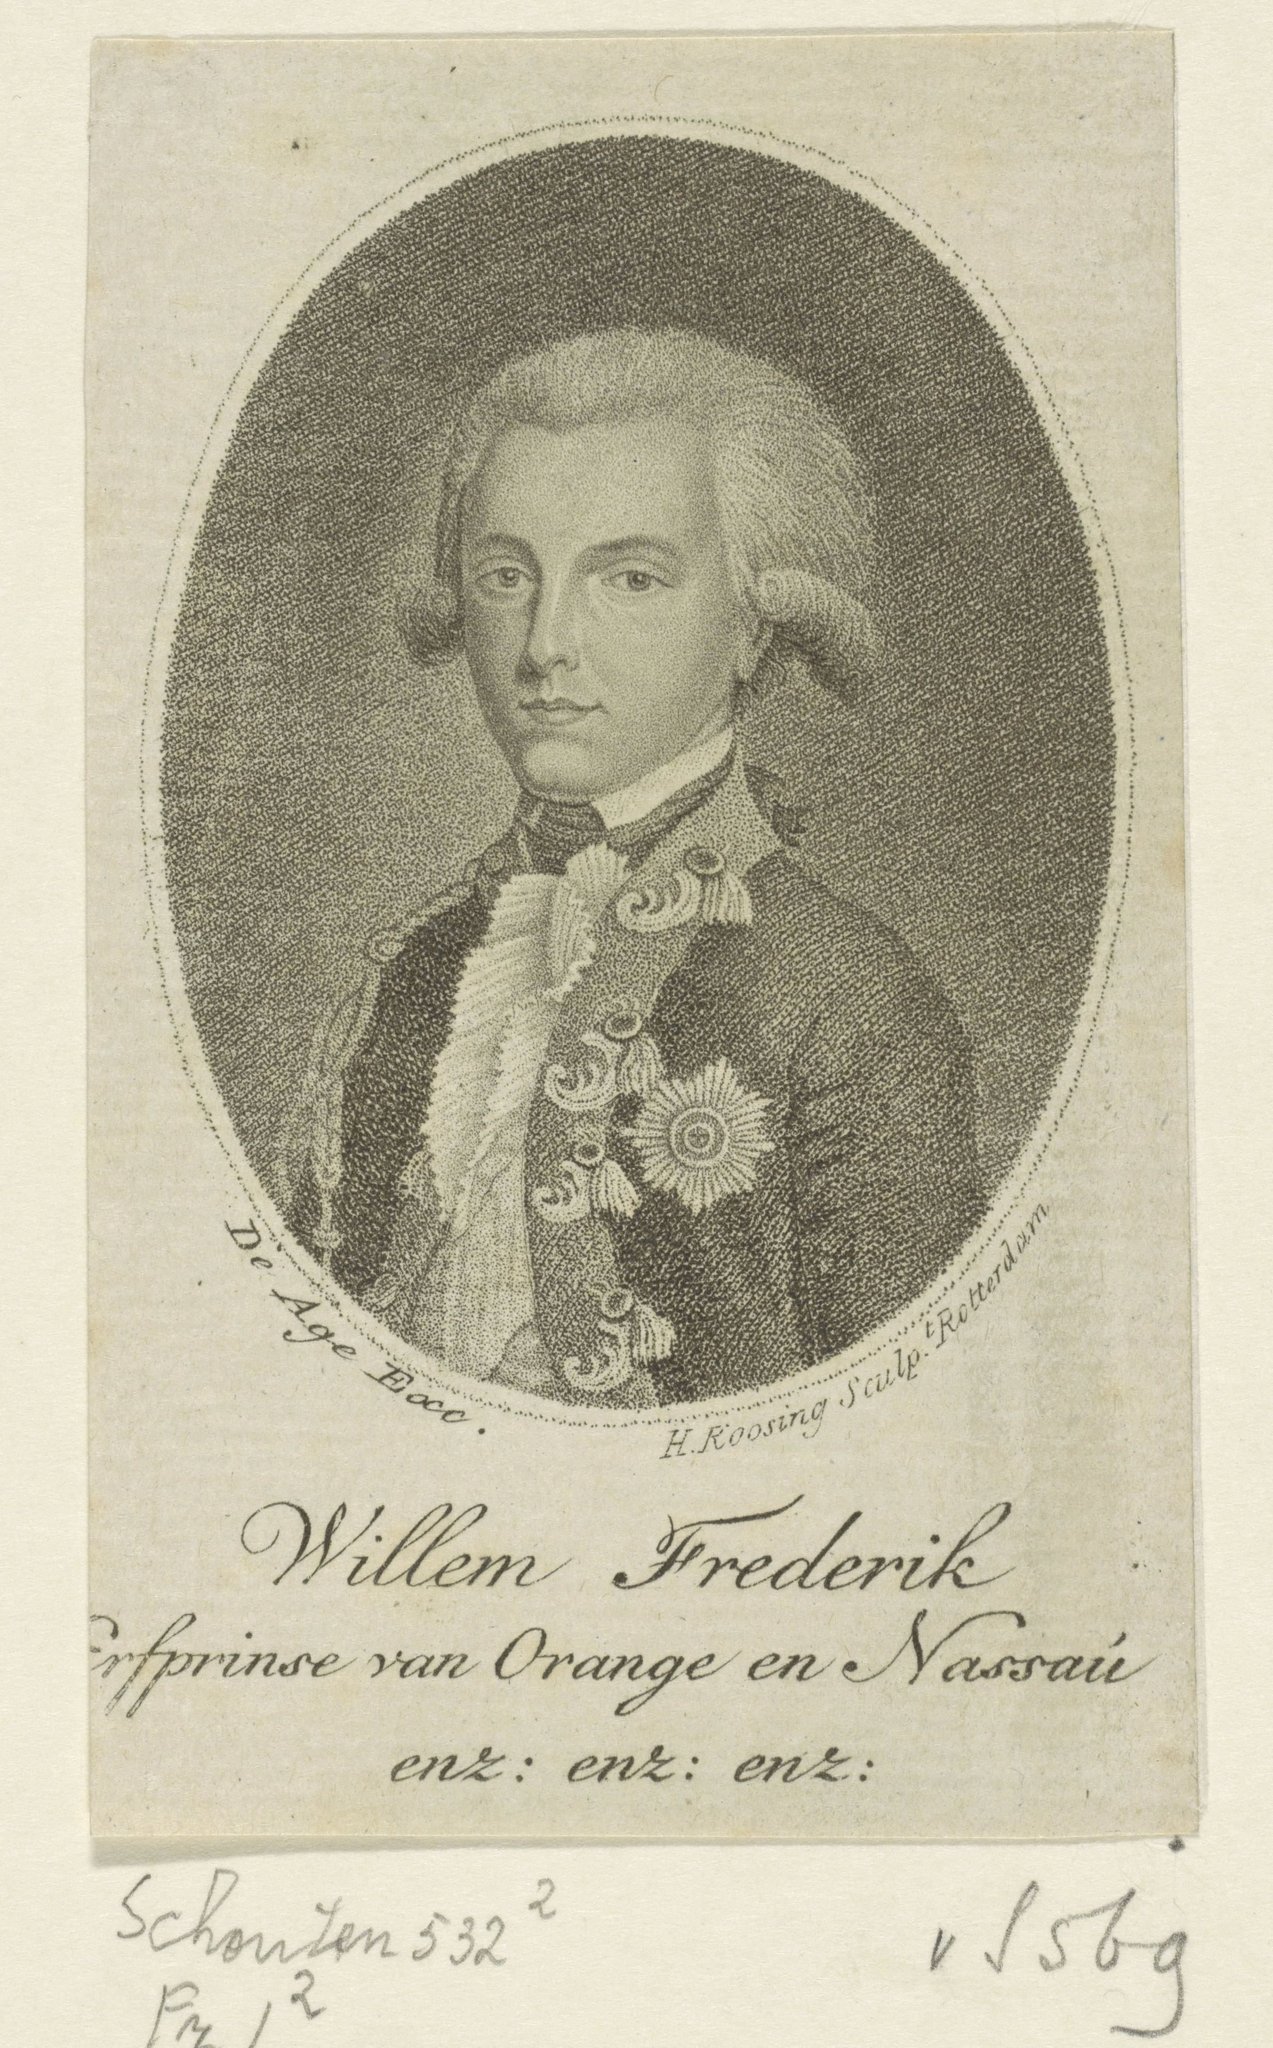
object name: print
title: Portret van Willem I Frederik, koning der Nederlanden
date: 1790-1801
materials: paper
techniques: engraving, etching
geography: the hague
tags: the hague, berlin, william i of the netherlands, knighthood order (with name) - insignia of a knighthood order, e.g.: badge, chain (with name of order)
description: De hier vermelde titel verwijst naar de hoogst verkregen titel van de geportretteerde, niet per se naar de titel die de geportretteerde op deze voorstelling draagt.